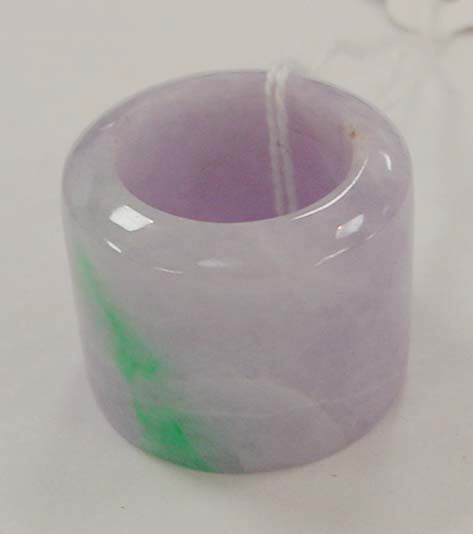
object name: ring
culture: chinese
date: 1801-1900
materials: jade